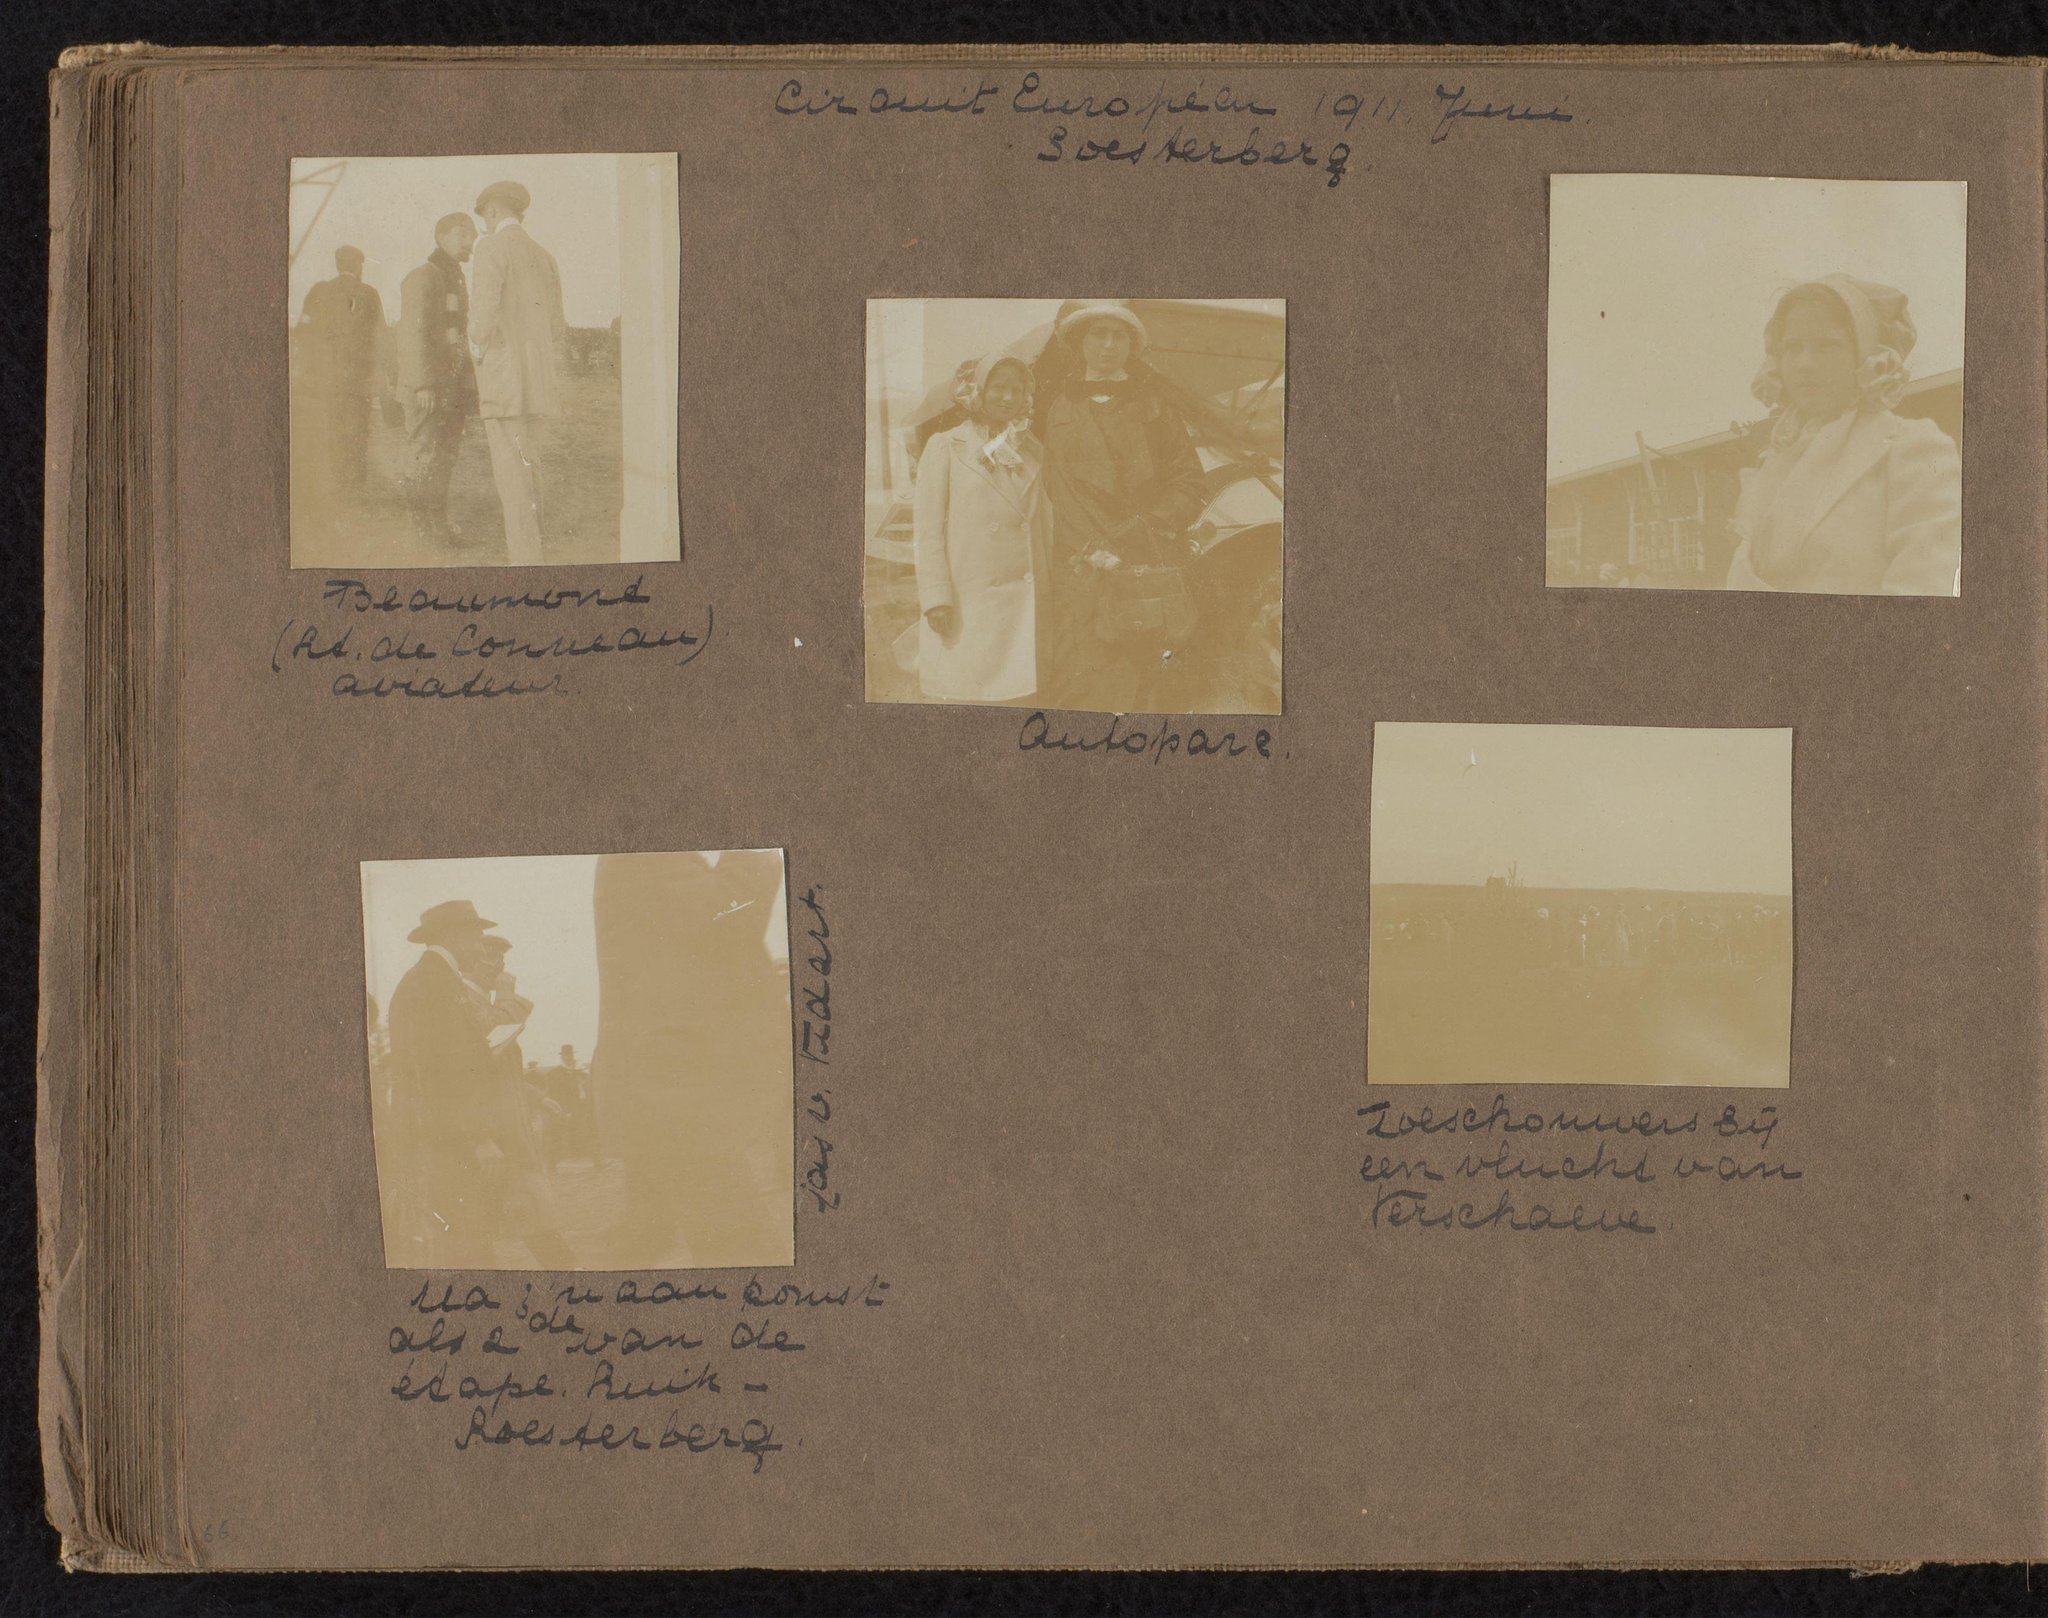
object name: photograph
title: Circuit Européen 1911 Juni Soesterberg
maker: carolina frederika onnen (lien/loen)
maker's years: 1896-1983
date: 1911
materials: paper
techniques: gelatin silver print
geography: soesterberg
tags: activities in the air ~ public festivities, e.g. fly-past, pilot, historical persons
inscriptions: inscription: ‘Beaumond/ (Rd. de Conneau)/ aviateur’, inscription: ‘Toeschouwers bij/ een vlucht van/ Verschaeve.’, inscription: ‘Autoparc.’, inscription: ‘jas v. Vidart/ Na z'n aankomst/ als 2de van de/ étape Luik-/ Soesterberg.’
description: Deze foto's maken deel uit van een album.